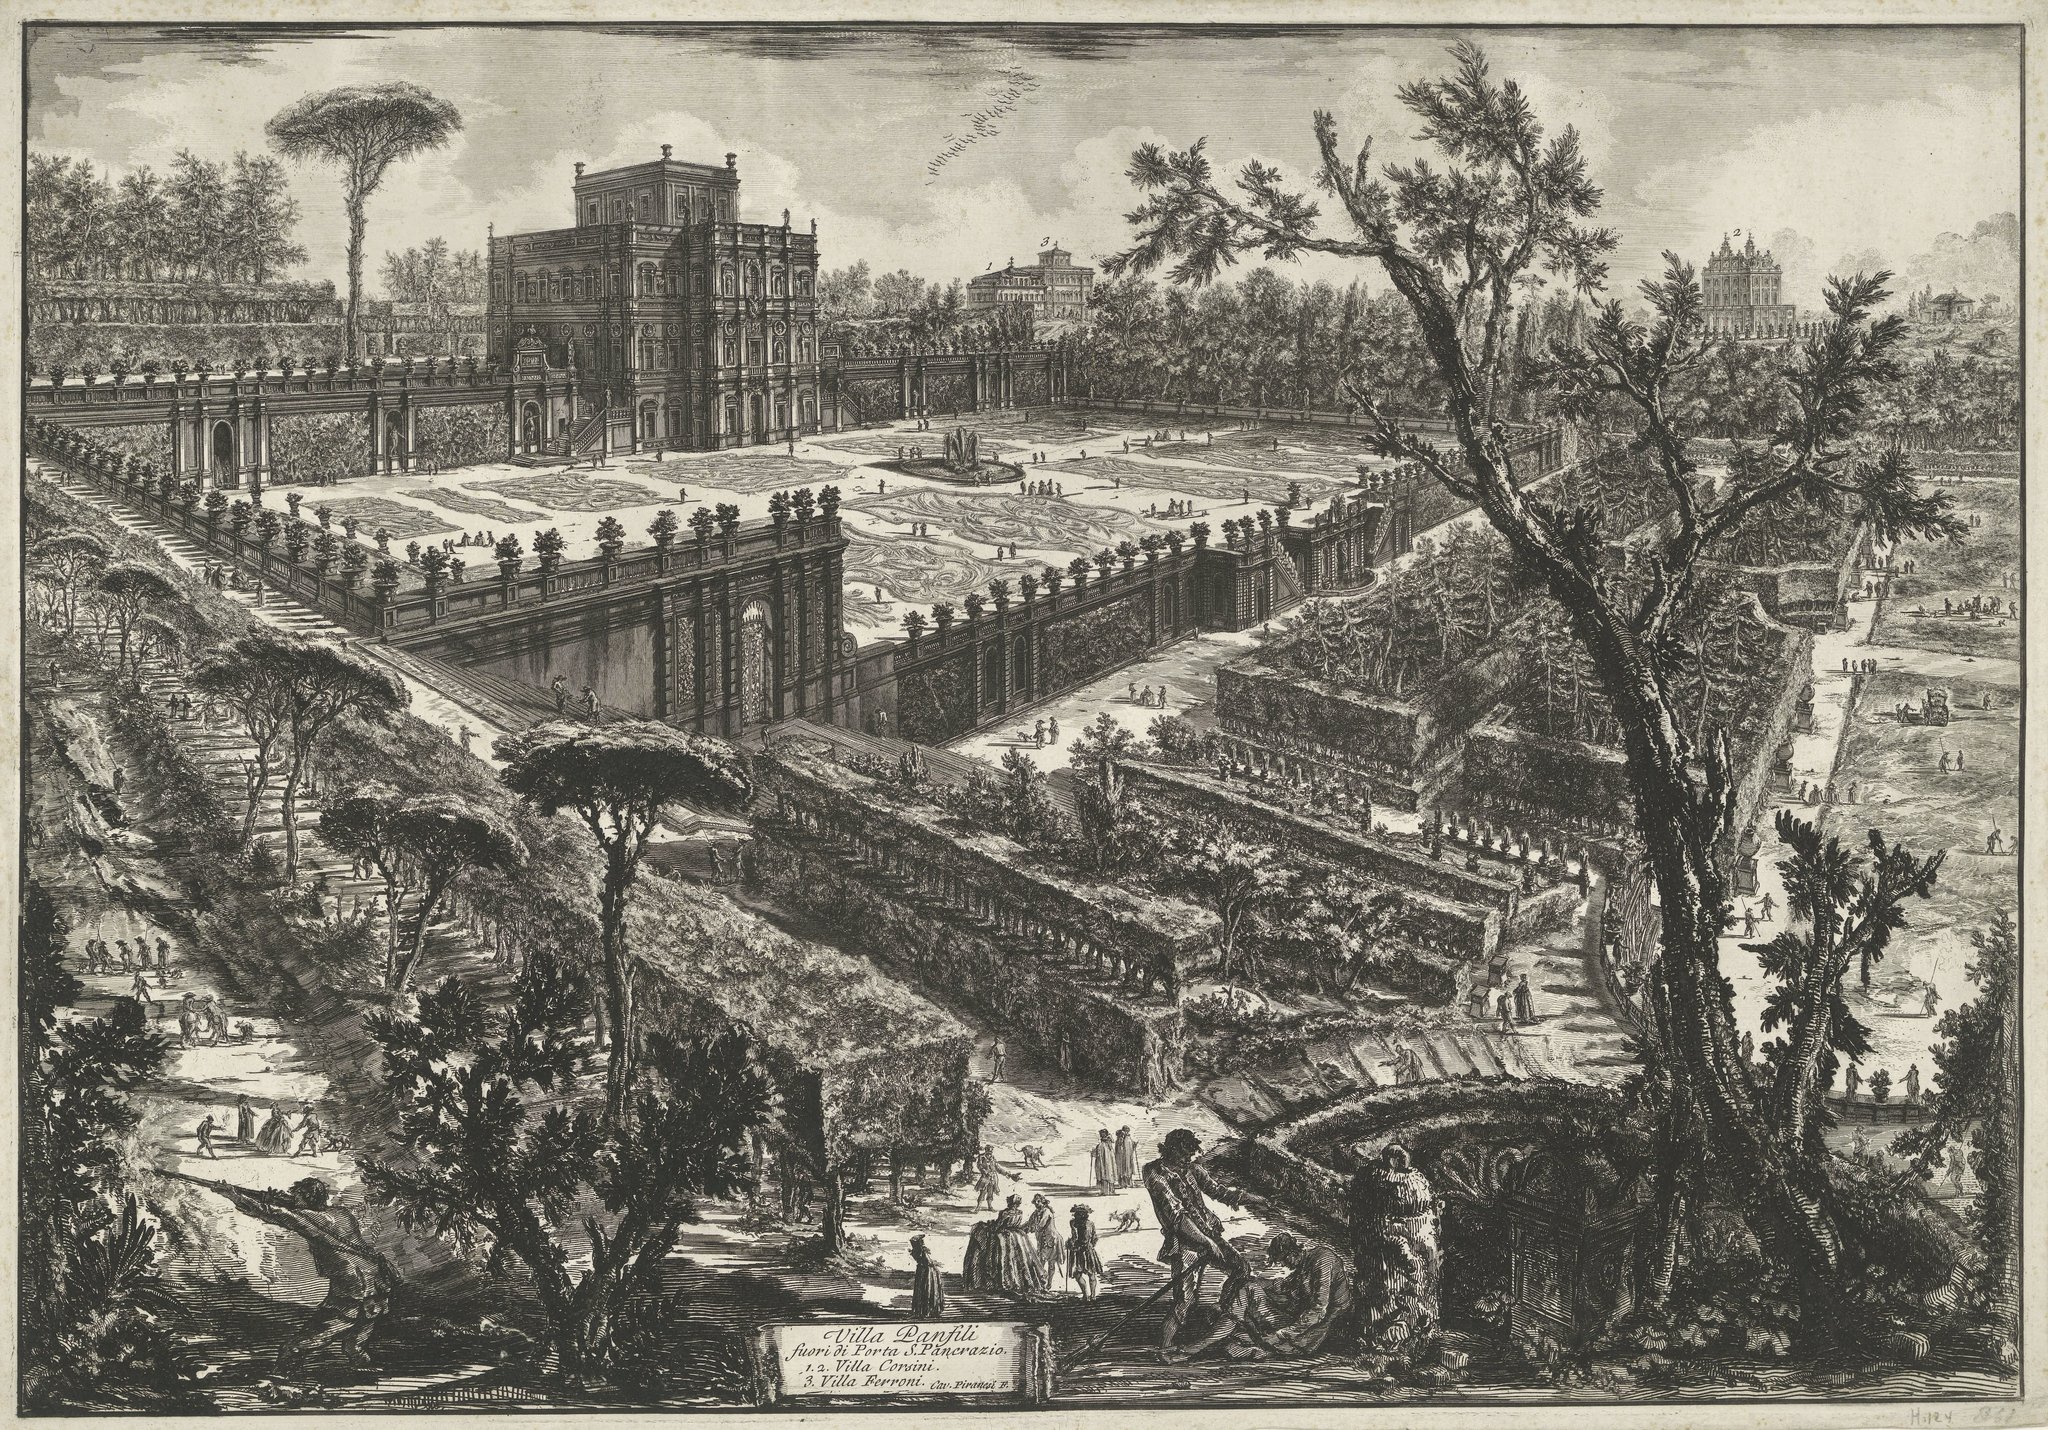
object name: print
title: Villa Panfili fuori di Porta S. Pancrazio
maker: giovanni battista piranesi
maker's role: designer, draughtsman, print maker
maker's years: 1720-1778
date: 1748-1778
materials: paper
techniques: etching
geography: rome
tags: garden, garden ornaments, villa, rome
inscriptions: collector's mark: Lugt 2228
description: Deze prent maakt deel uit van de serie 'Vedute di Roma'. Piranesi werkte aan deze 135 platen tellende serie tussen 1748 en zijn dood in 1778. Francesco Piranesi voegde later nog twee prenten toe aan de reeks van zijn vader.